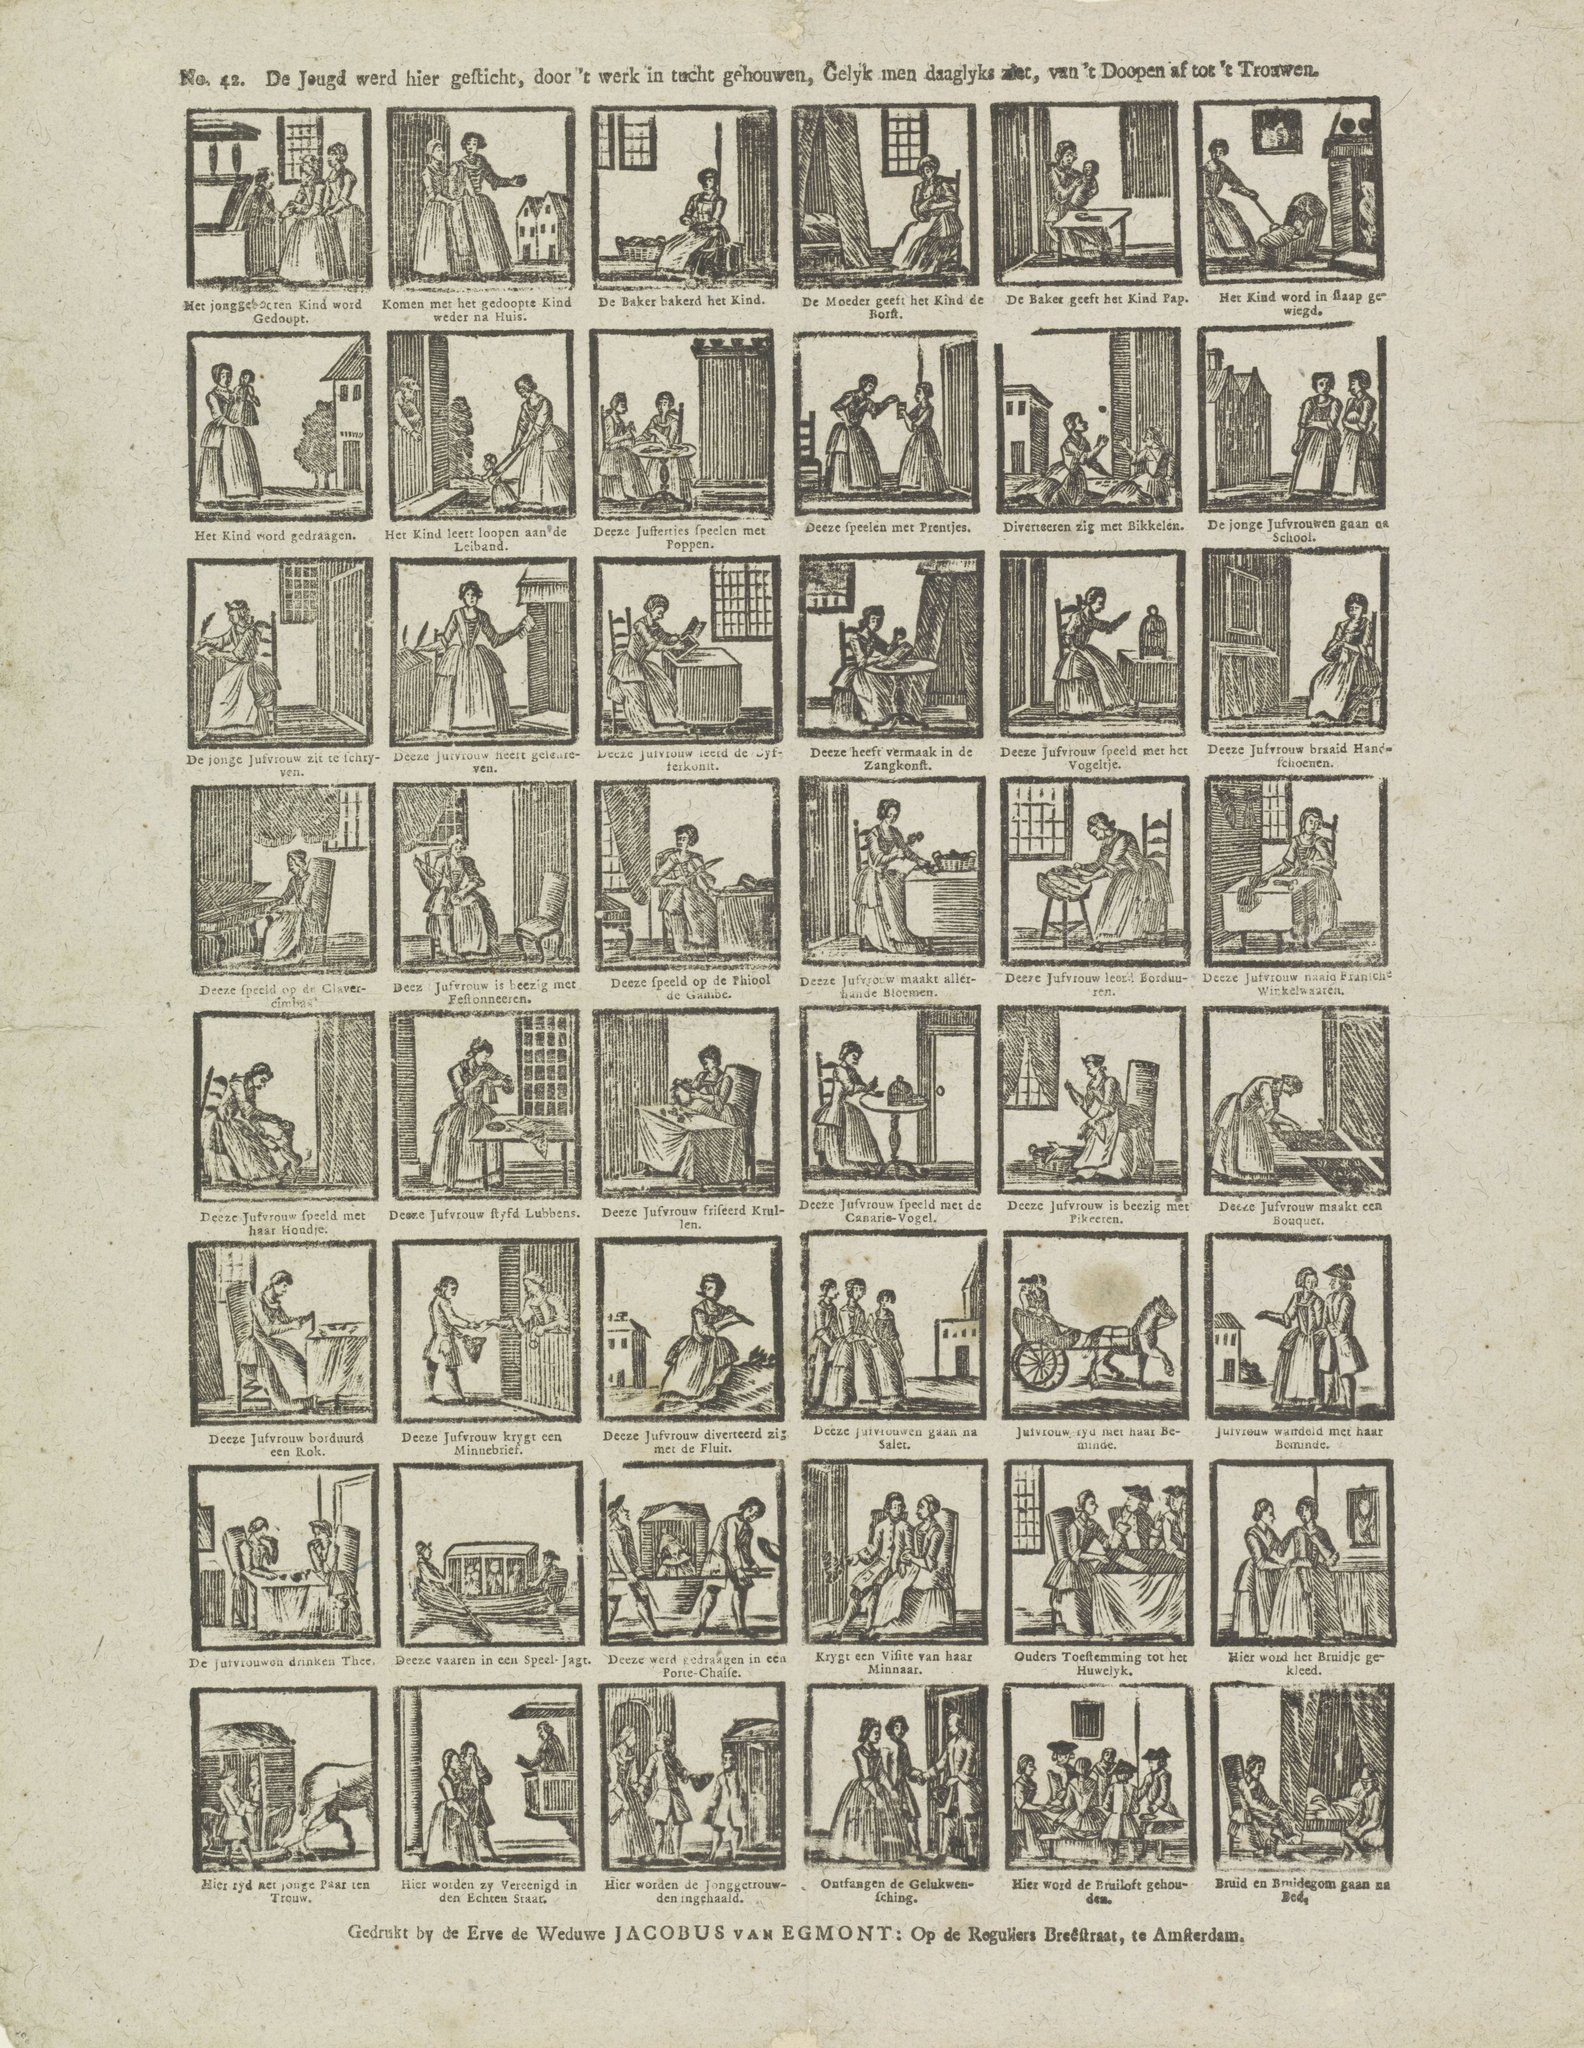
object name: print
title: De jeugd werd hier gesticht, door 't werk in tucht gehouwen, gelyk men daaglyks ziet, van 't doopen af tot 't trouwen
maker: Anonymous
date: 1761-1804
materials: paper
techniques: letterpress printing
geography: amsterdam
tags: human life divided into stages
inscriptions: collector's mark: Lugt 2760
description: Blad met 48 voorstellingen van momenten uit het menselijk leven van dopen tot trouwen. Onder elk plaatje een regel tekst. Genummerd linksboven: No. 42.